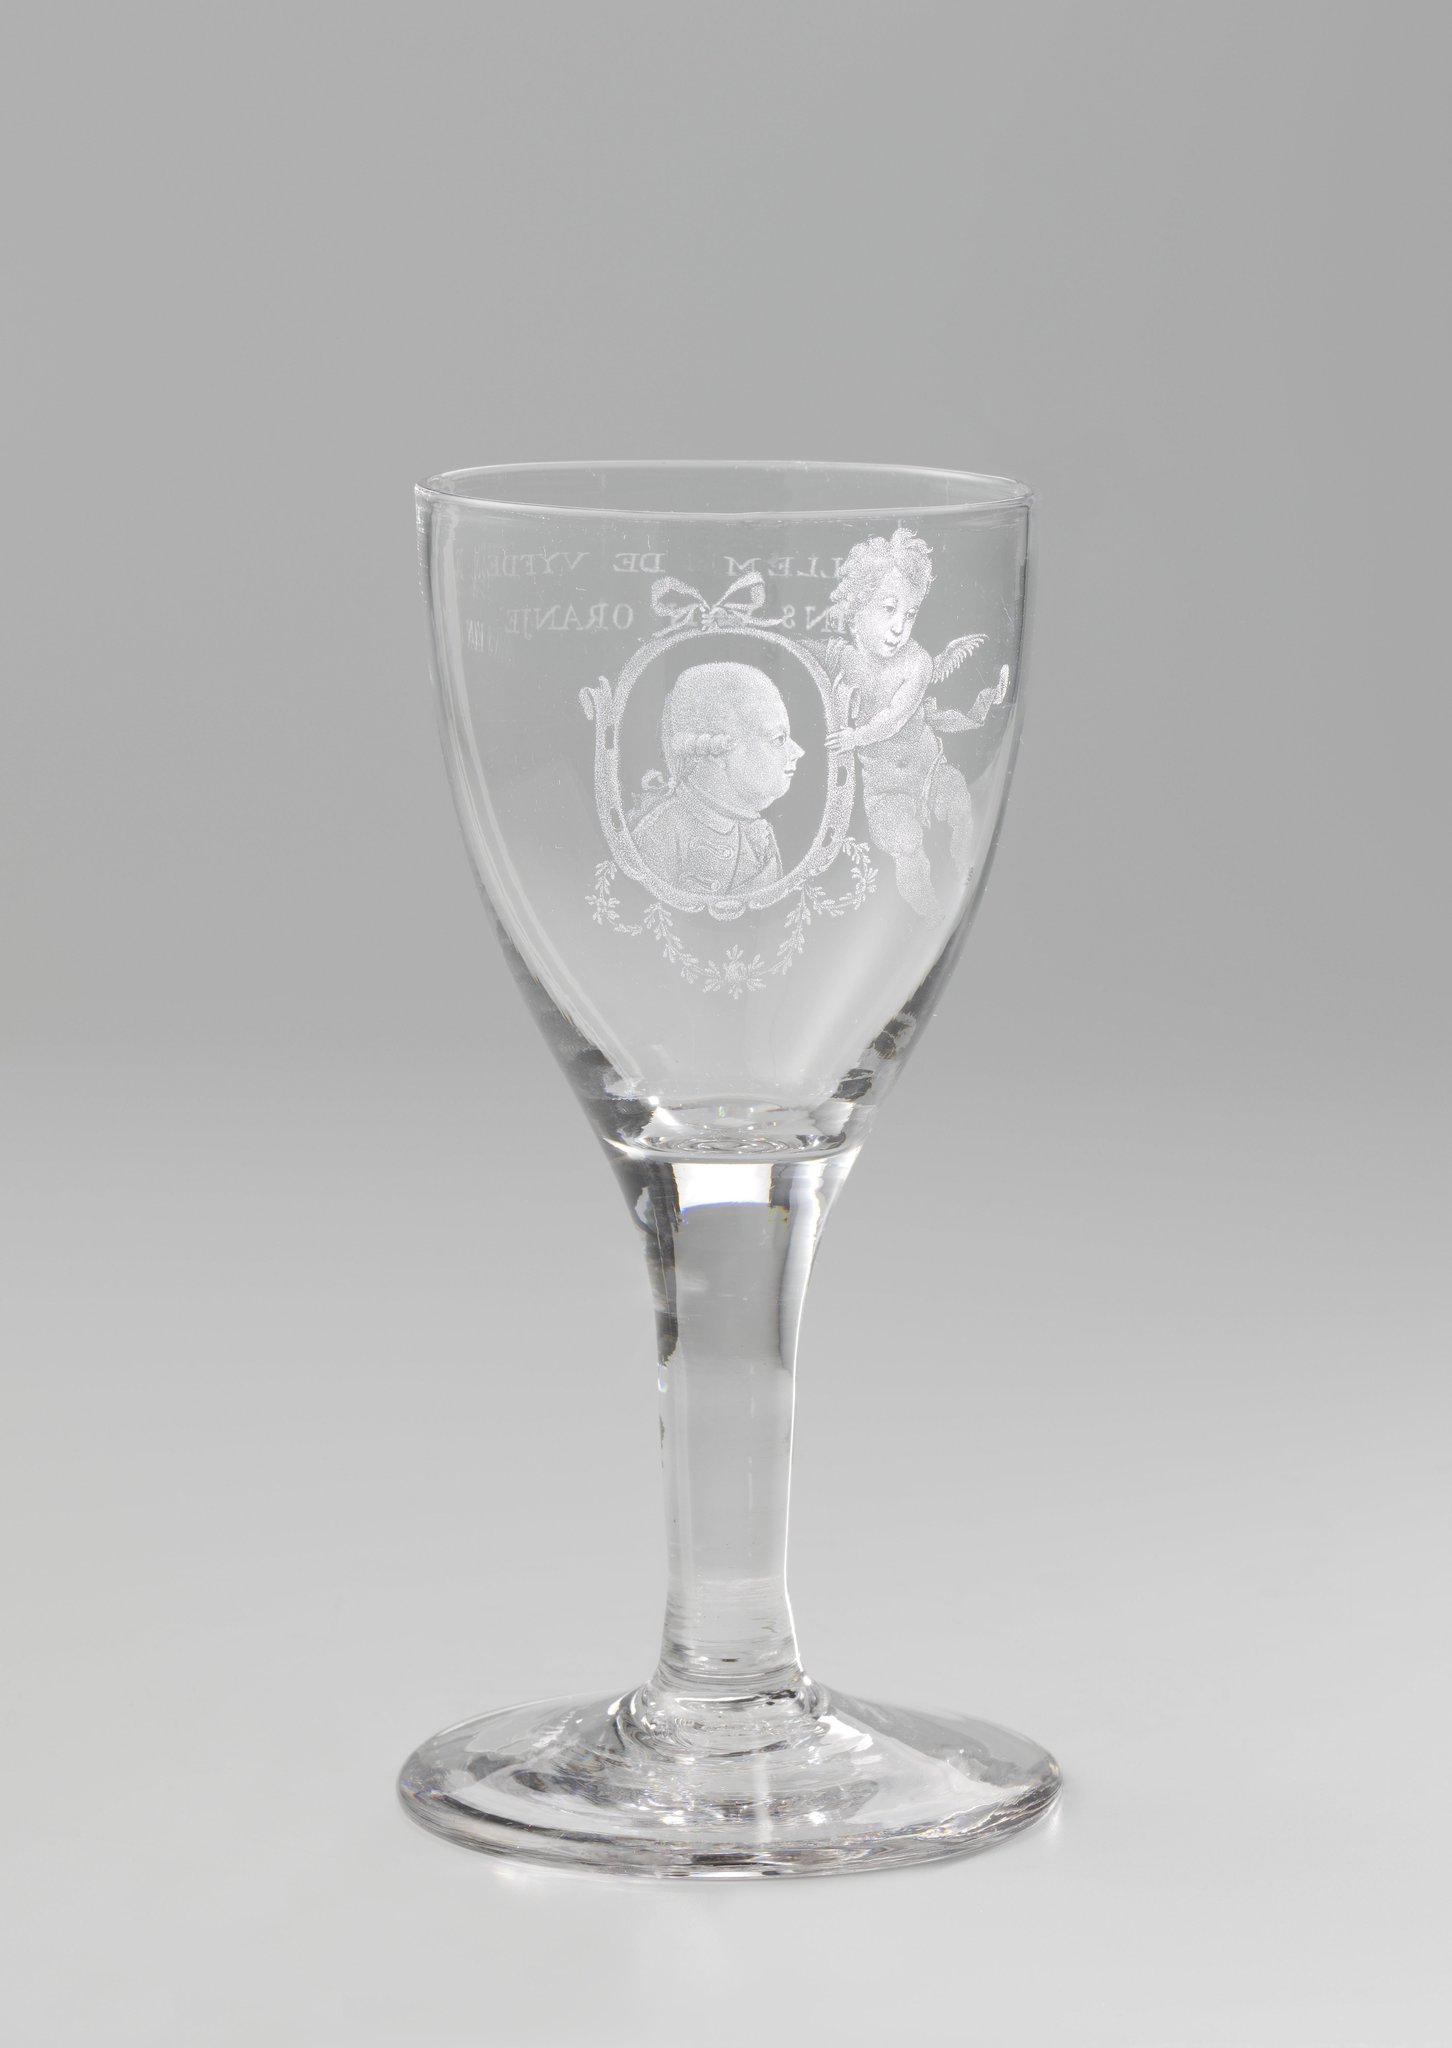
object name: goblet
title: Kelkglas met een portret van Willem V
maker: david wolff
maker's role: glasgraveur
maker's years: 1732-1798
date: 1775-1798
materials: glass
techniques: glassblowing, engraving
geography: northern netherlands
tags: the hague, william v (prince of orange), berlin, painter, draughtsman, wilhelmina of prussia (princess of orange)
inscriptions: inscription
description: Portrait of Stadholder William V, c. 1775 - 1798. Given by B. van der Star, 1836.